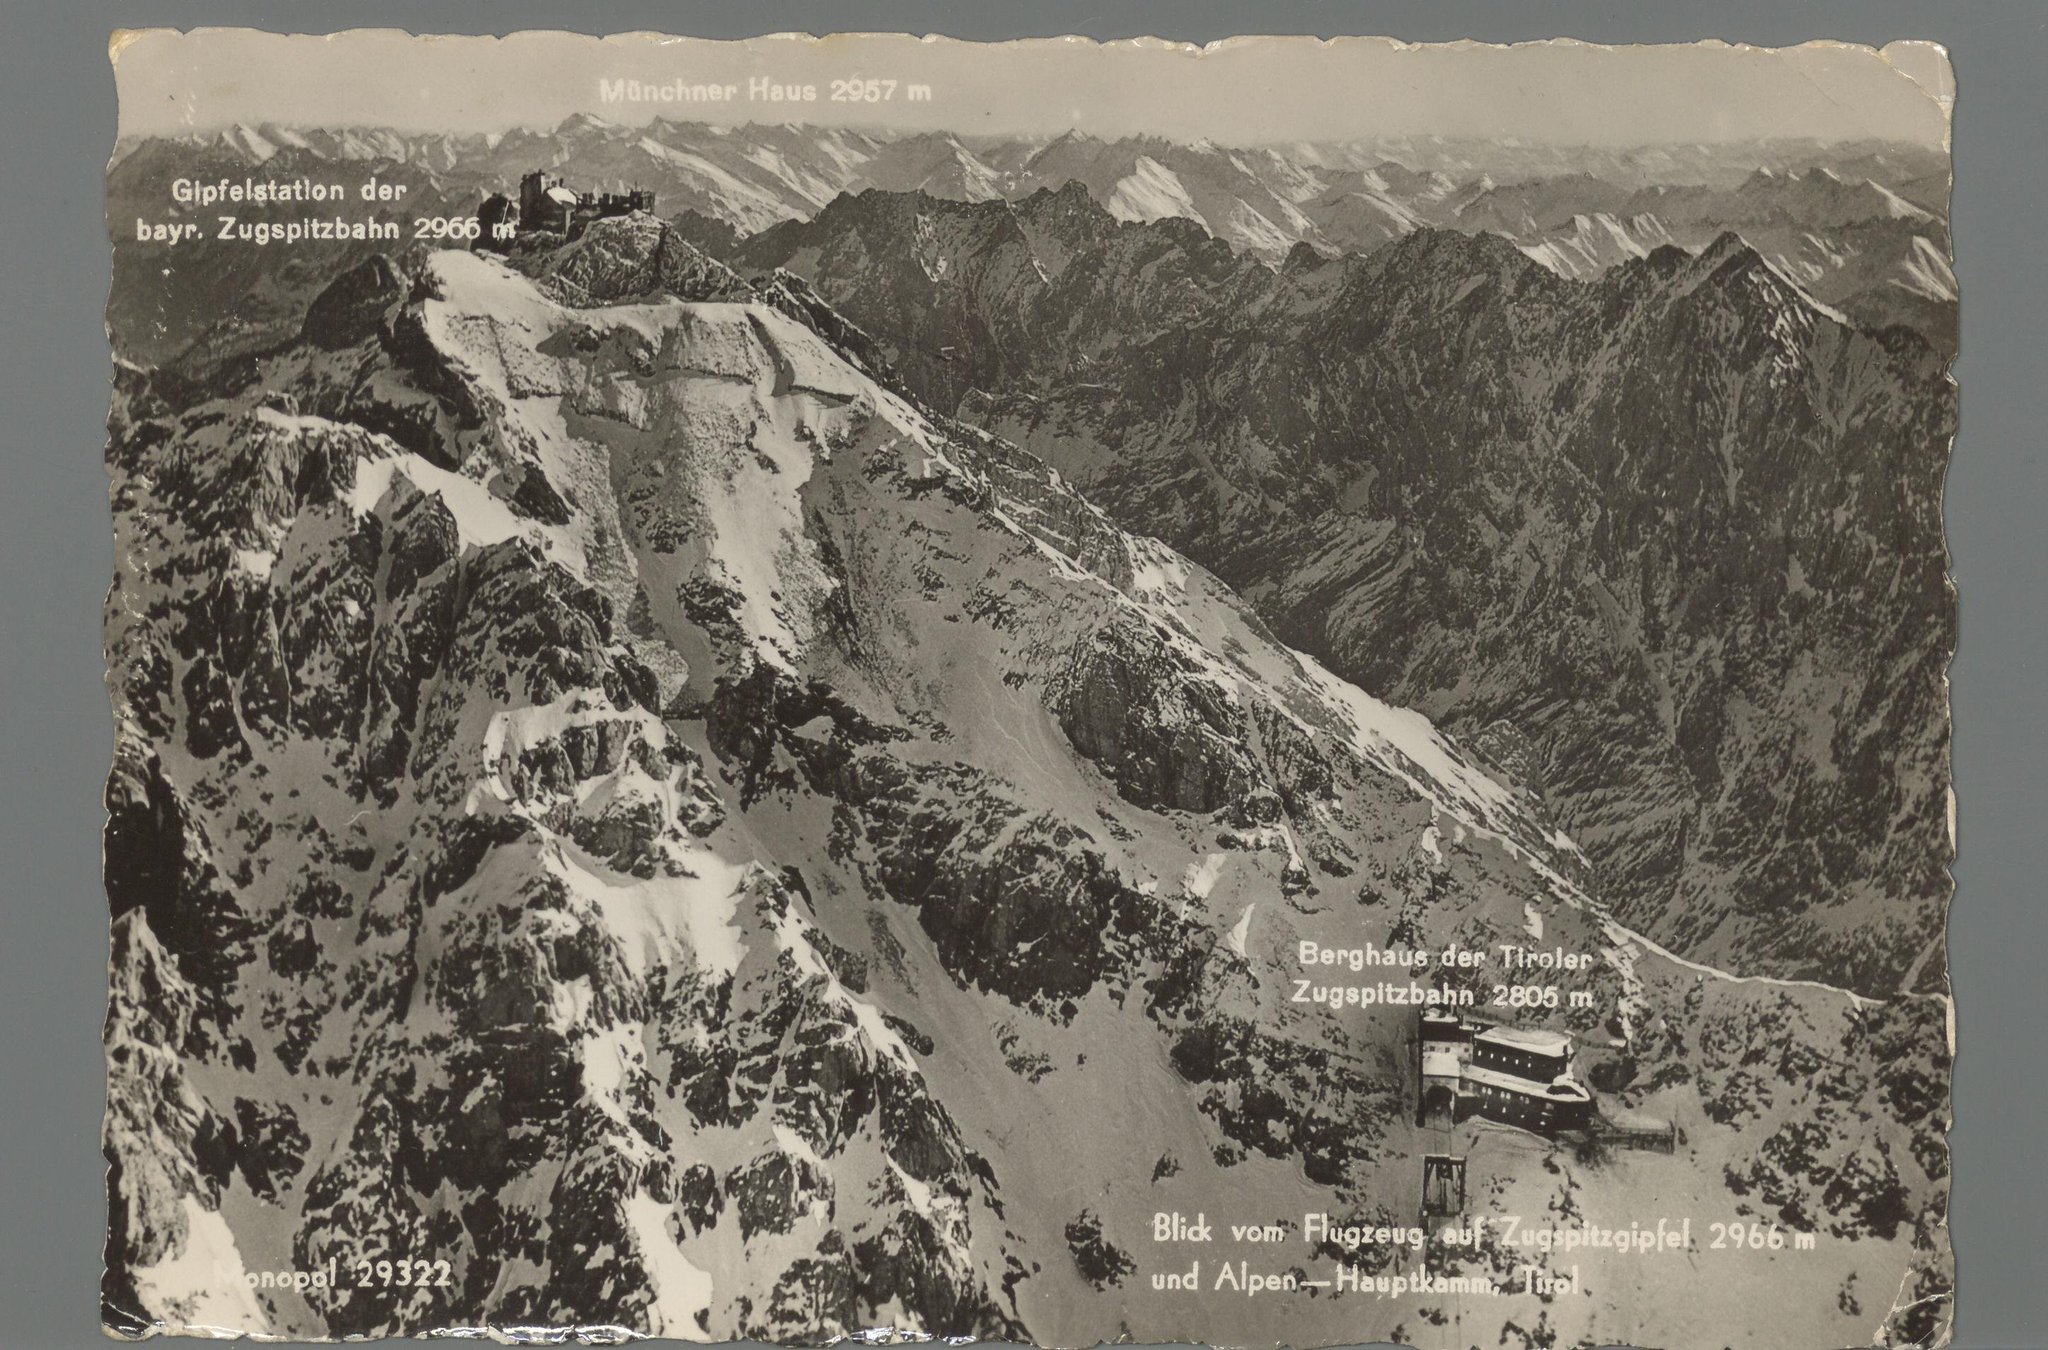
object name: ansichtkaart, prentbriefkaart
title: Blick vom Flugzeug auf Zugspitzgipfel 2966 m und Alpen- Hauptkamm, Tirol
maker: Anonymous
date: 1929-1953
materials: photographic support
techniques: photography, writing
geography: innsbruck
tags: mountain-range, snow peaks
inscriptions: postage stamp